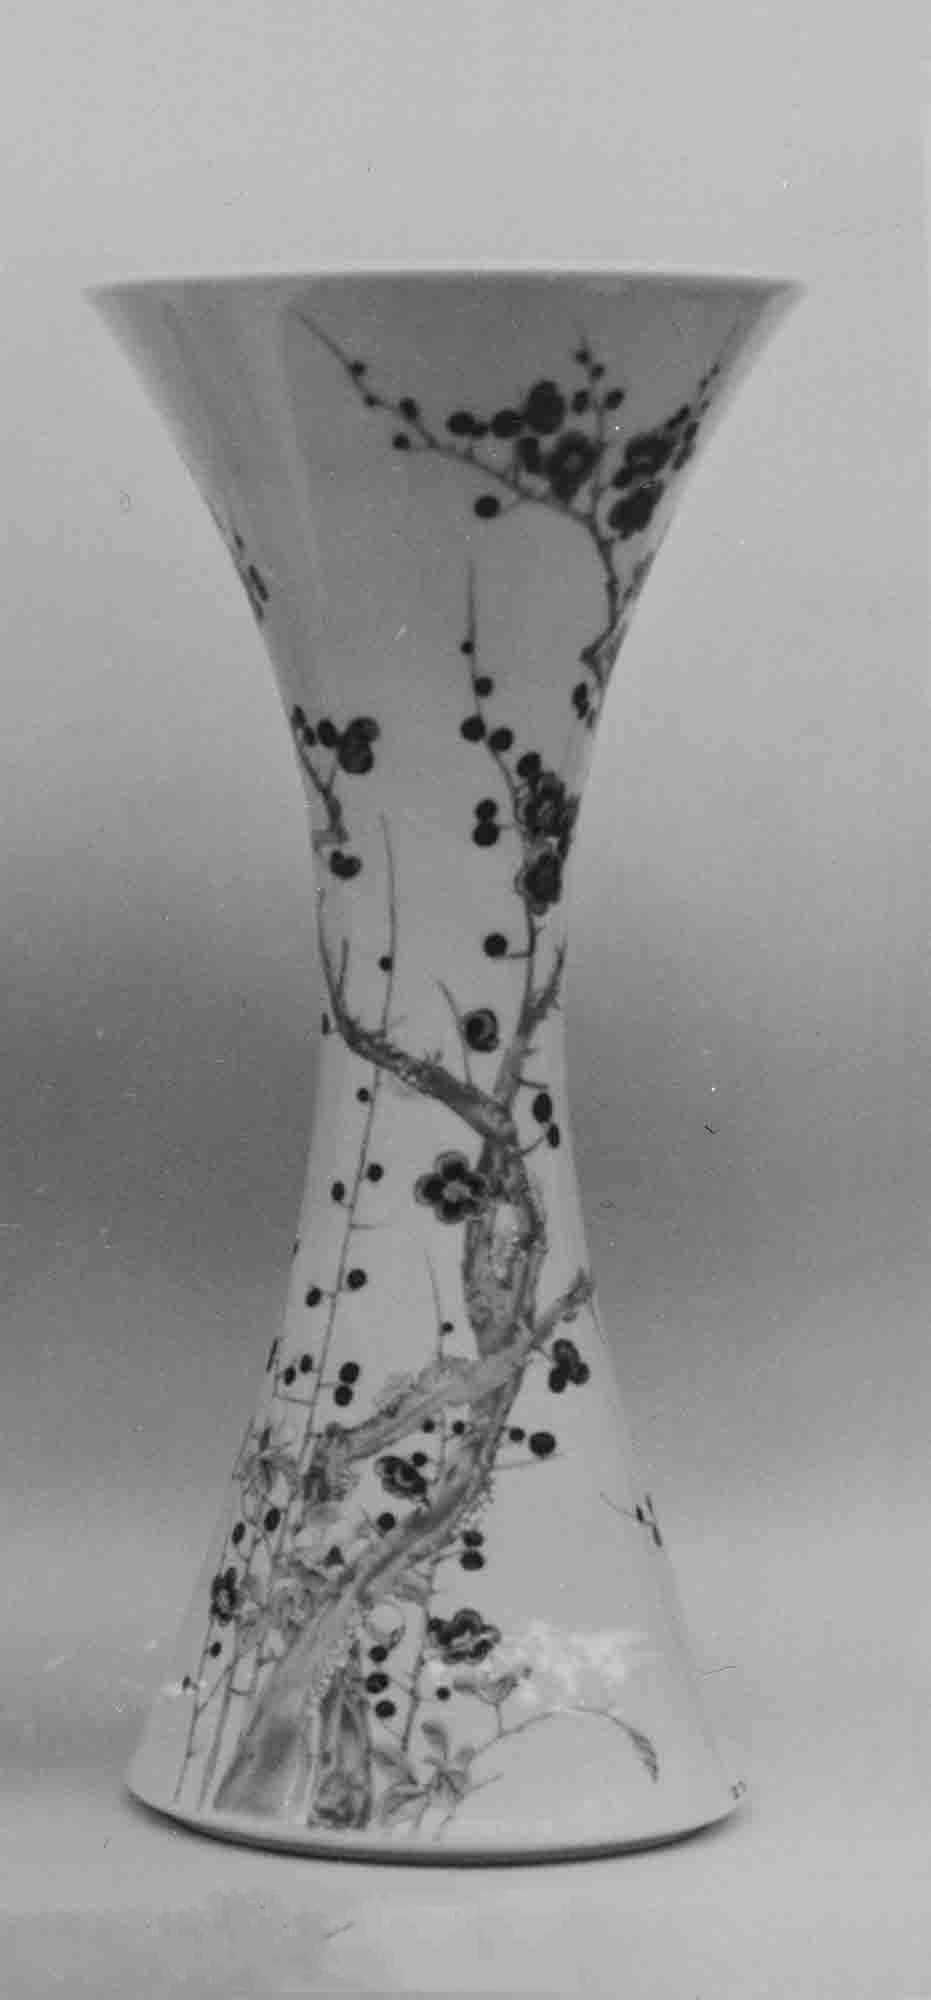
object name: vase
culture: japanese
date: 1860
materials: porcelain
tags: trees